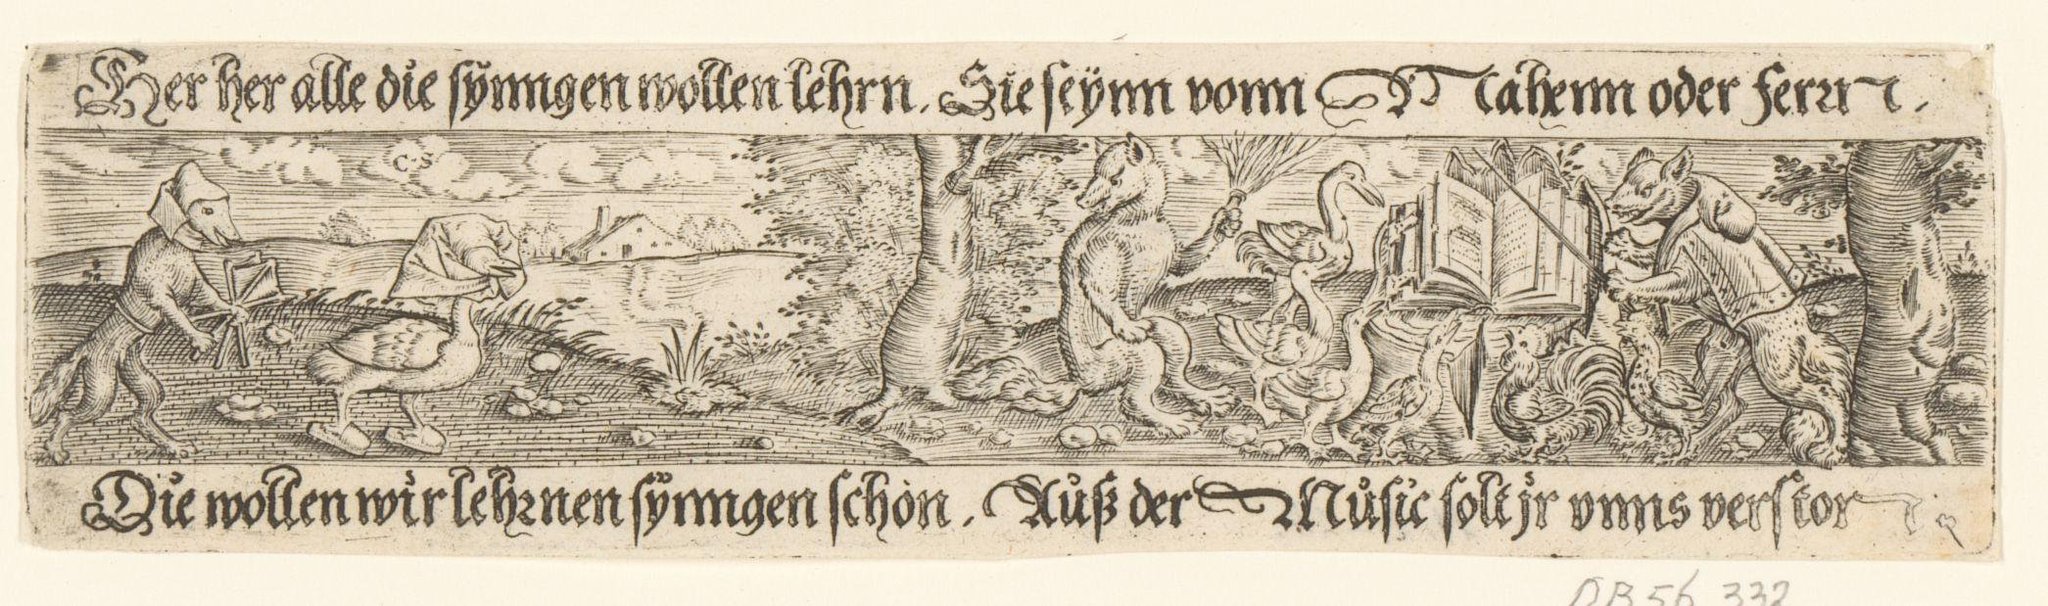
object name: print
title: Satirische scènes met dieren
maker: conrad saldörffer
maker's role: print maker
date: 1563-1583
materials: paper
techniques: etching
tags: fowl (cock, hen, chicken, etc.), beasts of prey, predatory animals: wolf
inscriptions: collector's mark: Lugt 2228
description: Onderdeel van een serie satirische prenten met dieren, waarvan de complete hoeveelheid onbekend is.